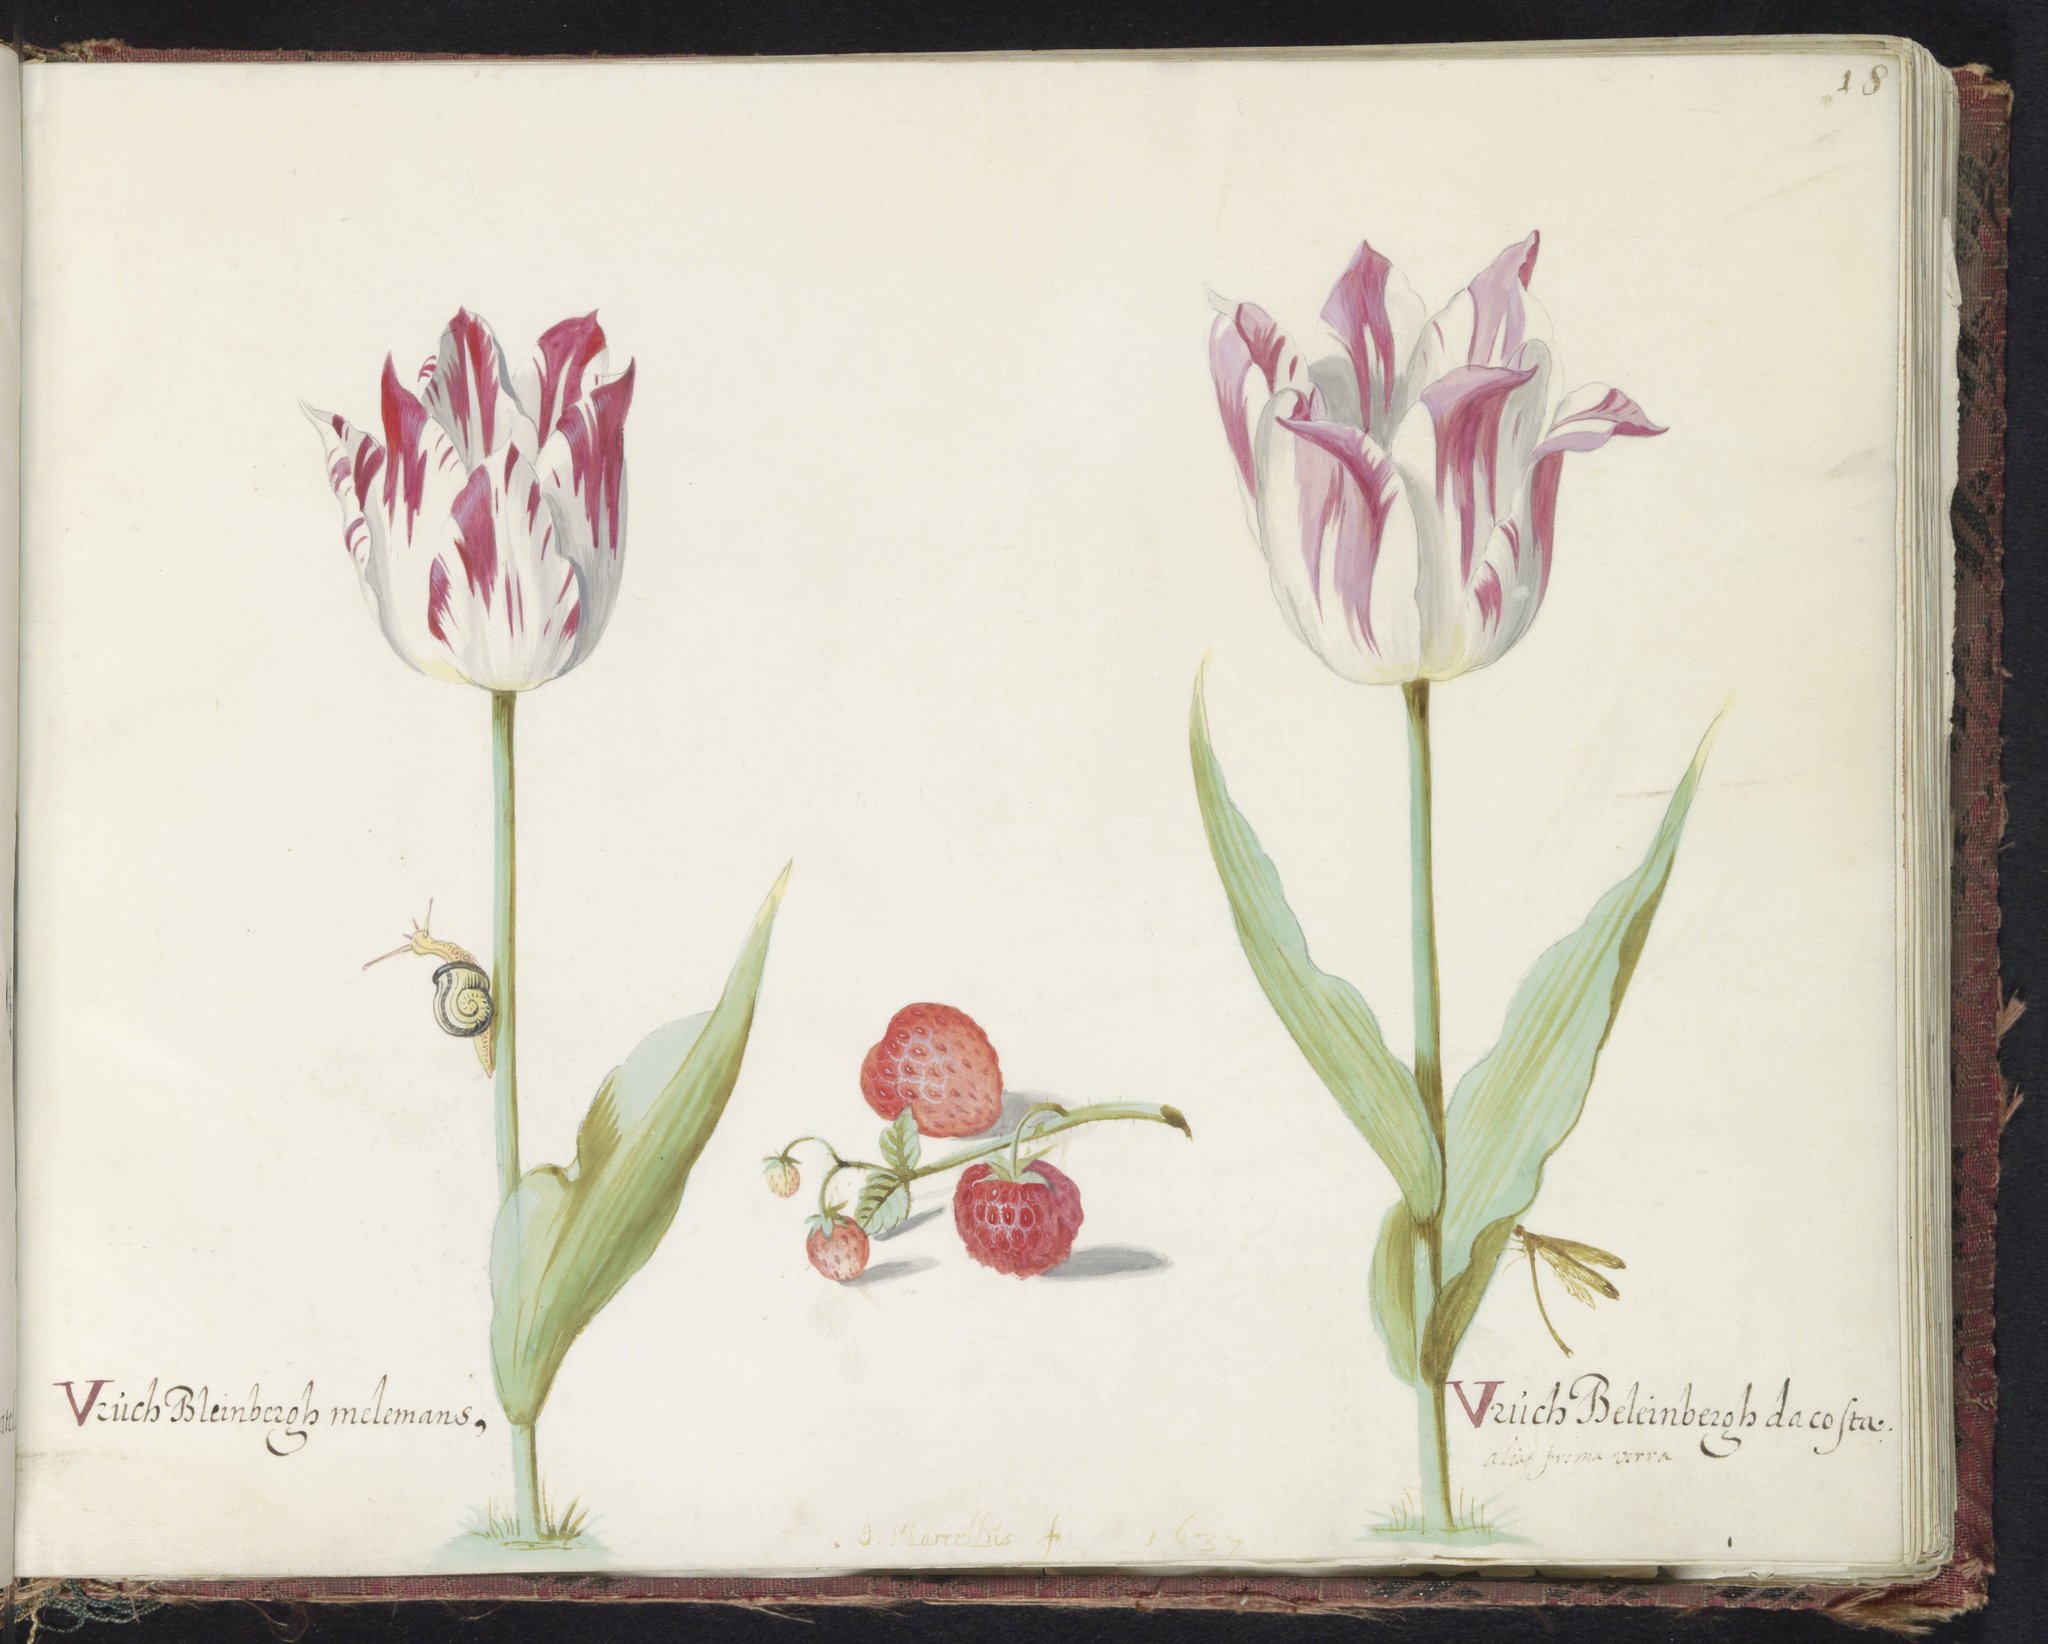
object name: album leaf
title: Twee tulpen met aardbeien en slak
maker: jacob marrel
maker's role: draughtsman, painter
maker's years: 1614-1681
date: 1637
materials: paint, parchment, pencil, watercolor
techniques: brush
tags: fruits: strawberry, flowers: tulip, molluscs: snail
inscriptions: date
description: De tekening maakt deel uit van een album.